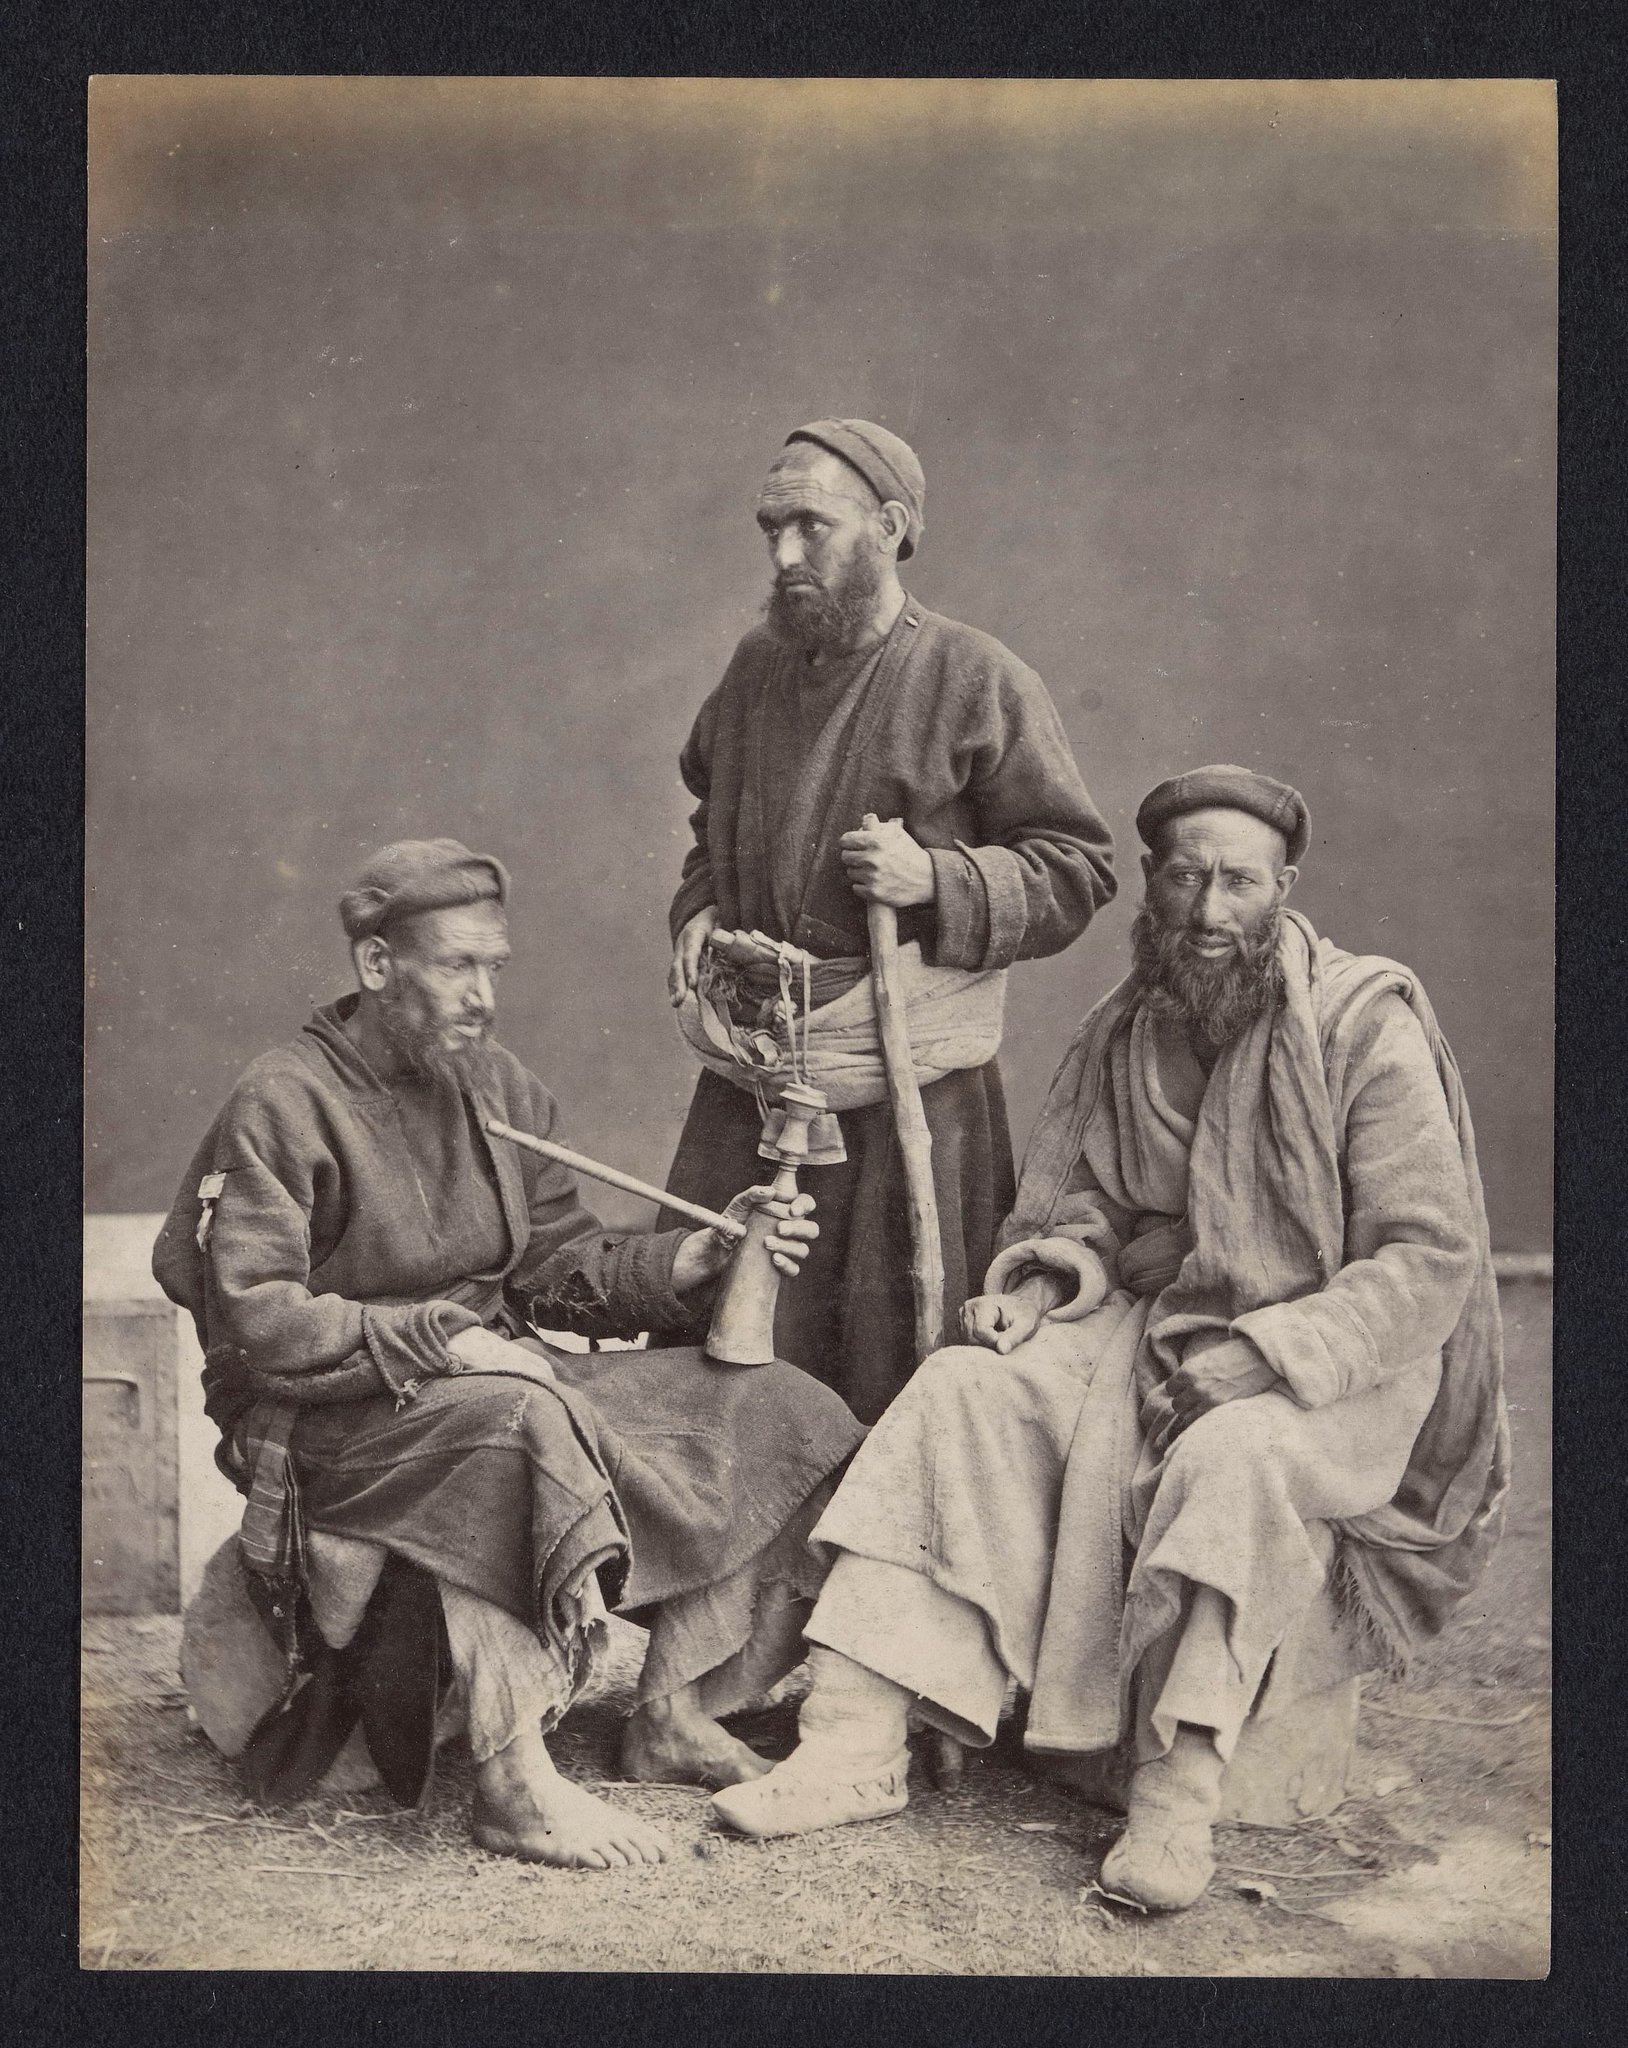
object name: photograph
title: Group portrait of three Balti men in Srinagar, Jammu & Kashmir, India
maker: frank mason good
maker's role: publisher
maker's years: 1839-1928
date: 1869-1875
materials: paper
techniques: albumen print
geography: jammu and kashmir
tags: adult man, anonymous historical person portrayed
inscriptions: title: ‘Group from Ladock’, number: ‘1/ 3214’